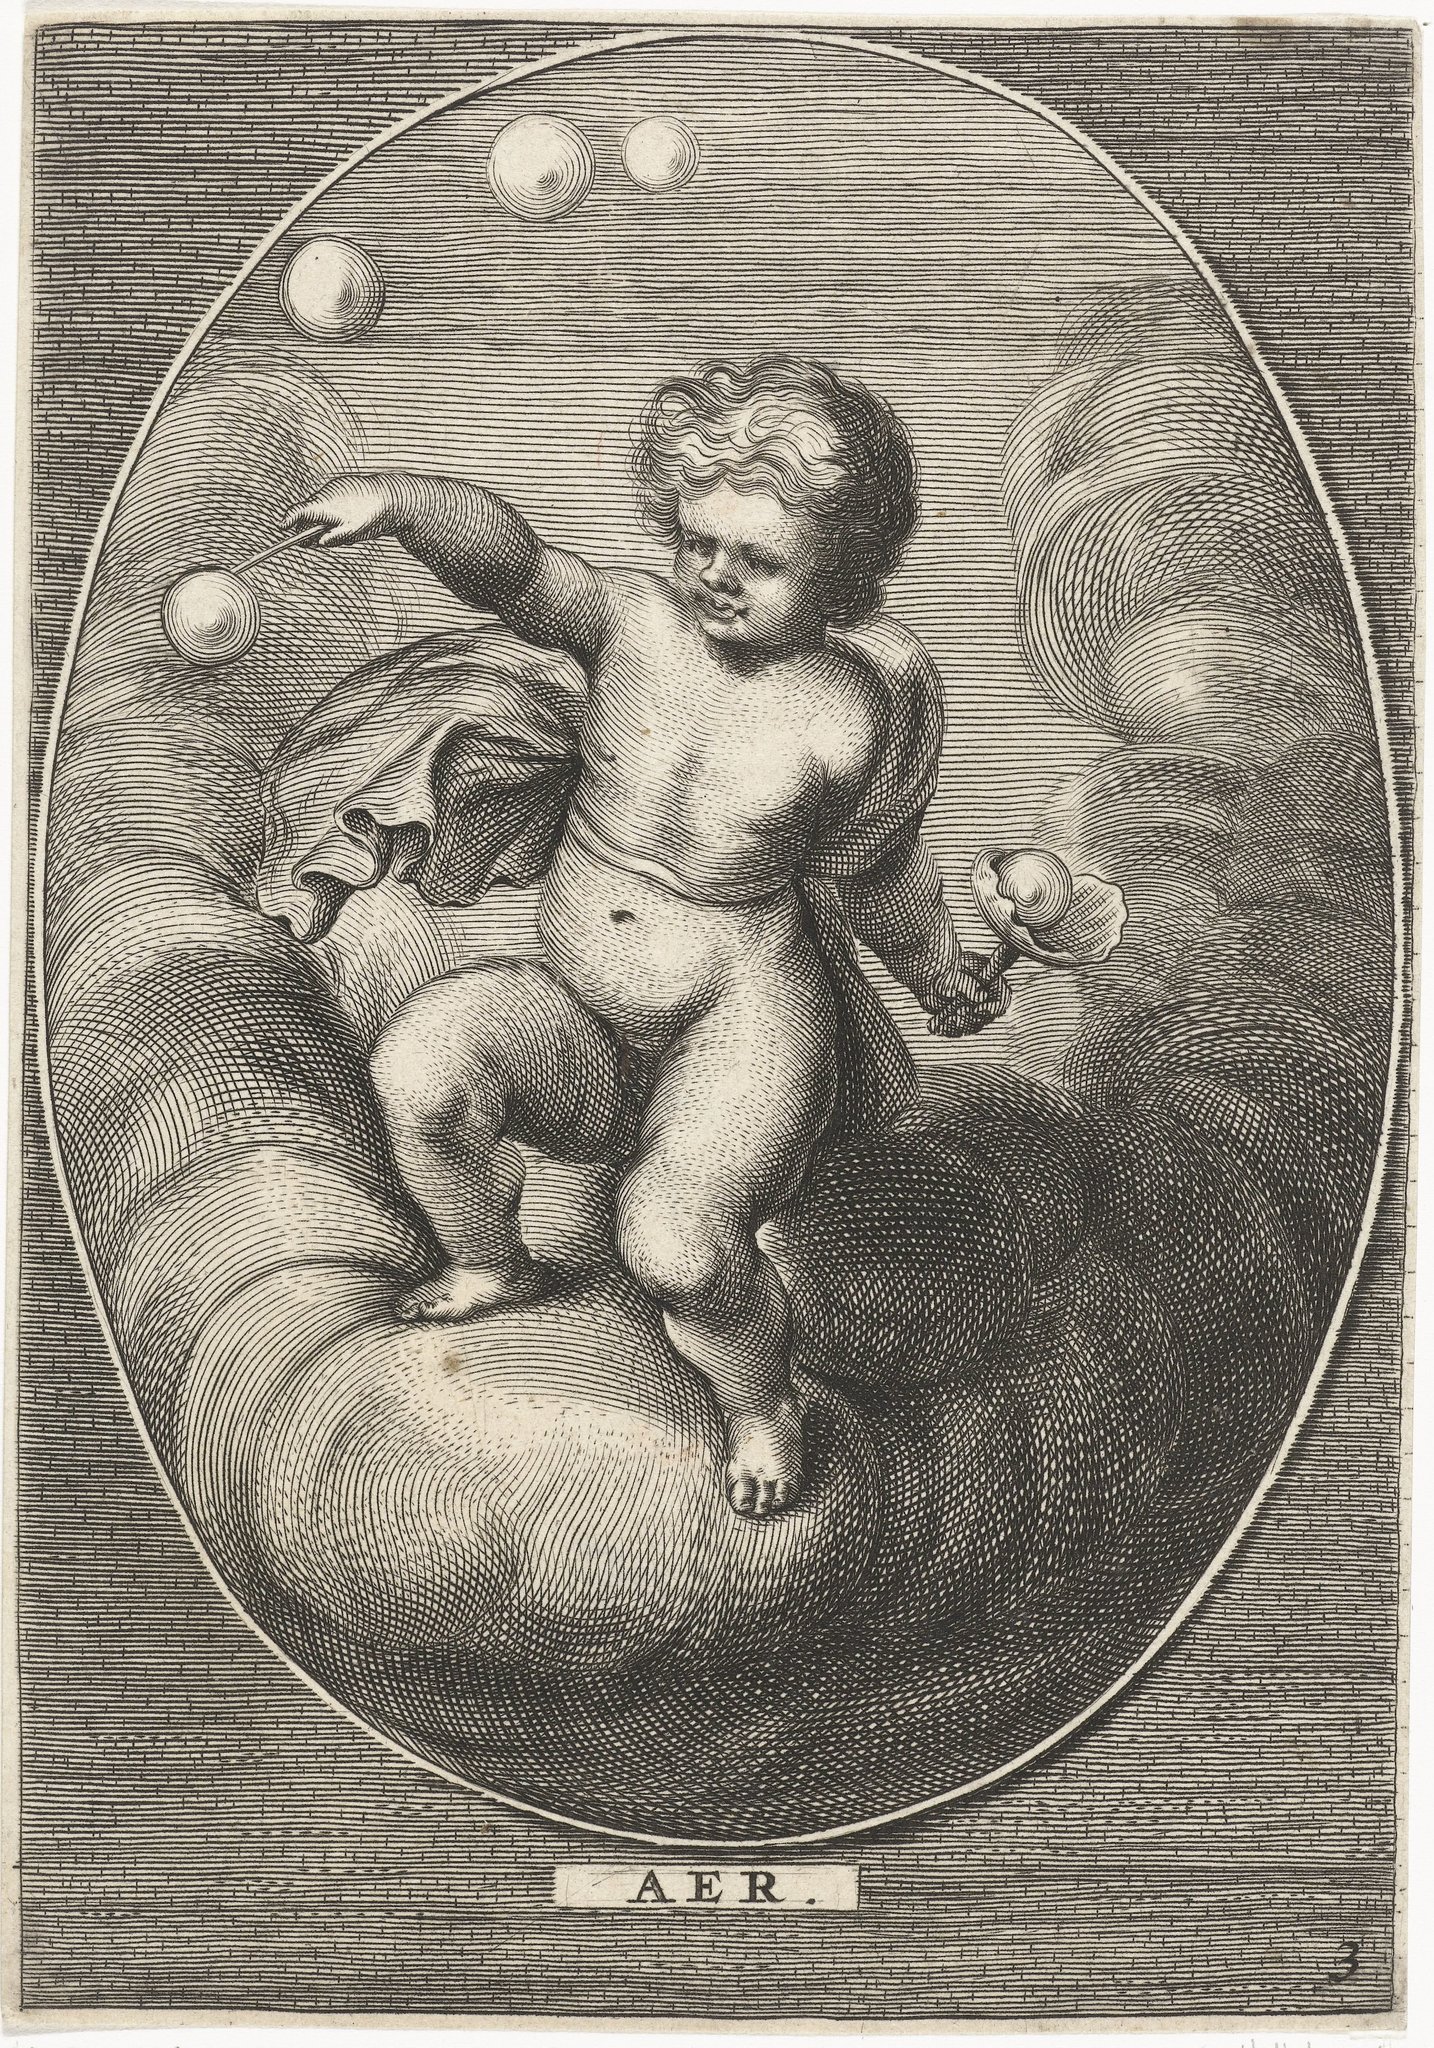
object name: print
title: Element lucht als kind dat bellen blaast op wolk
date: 1648-1706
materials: paper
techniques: engraving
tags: bubble-blowing (children's games and plays), air (one of the four elements), soap-bubble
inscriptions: collector's mark: Lugt 2228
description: Kopie naar prent van Cornelis van Dalen (II) uit serie van vier prenten met de vier elementen naar ontwerp van Abraham van Diepenbeeck.